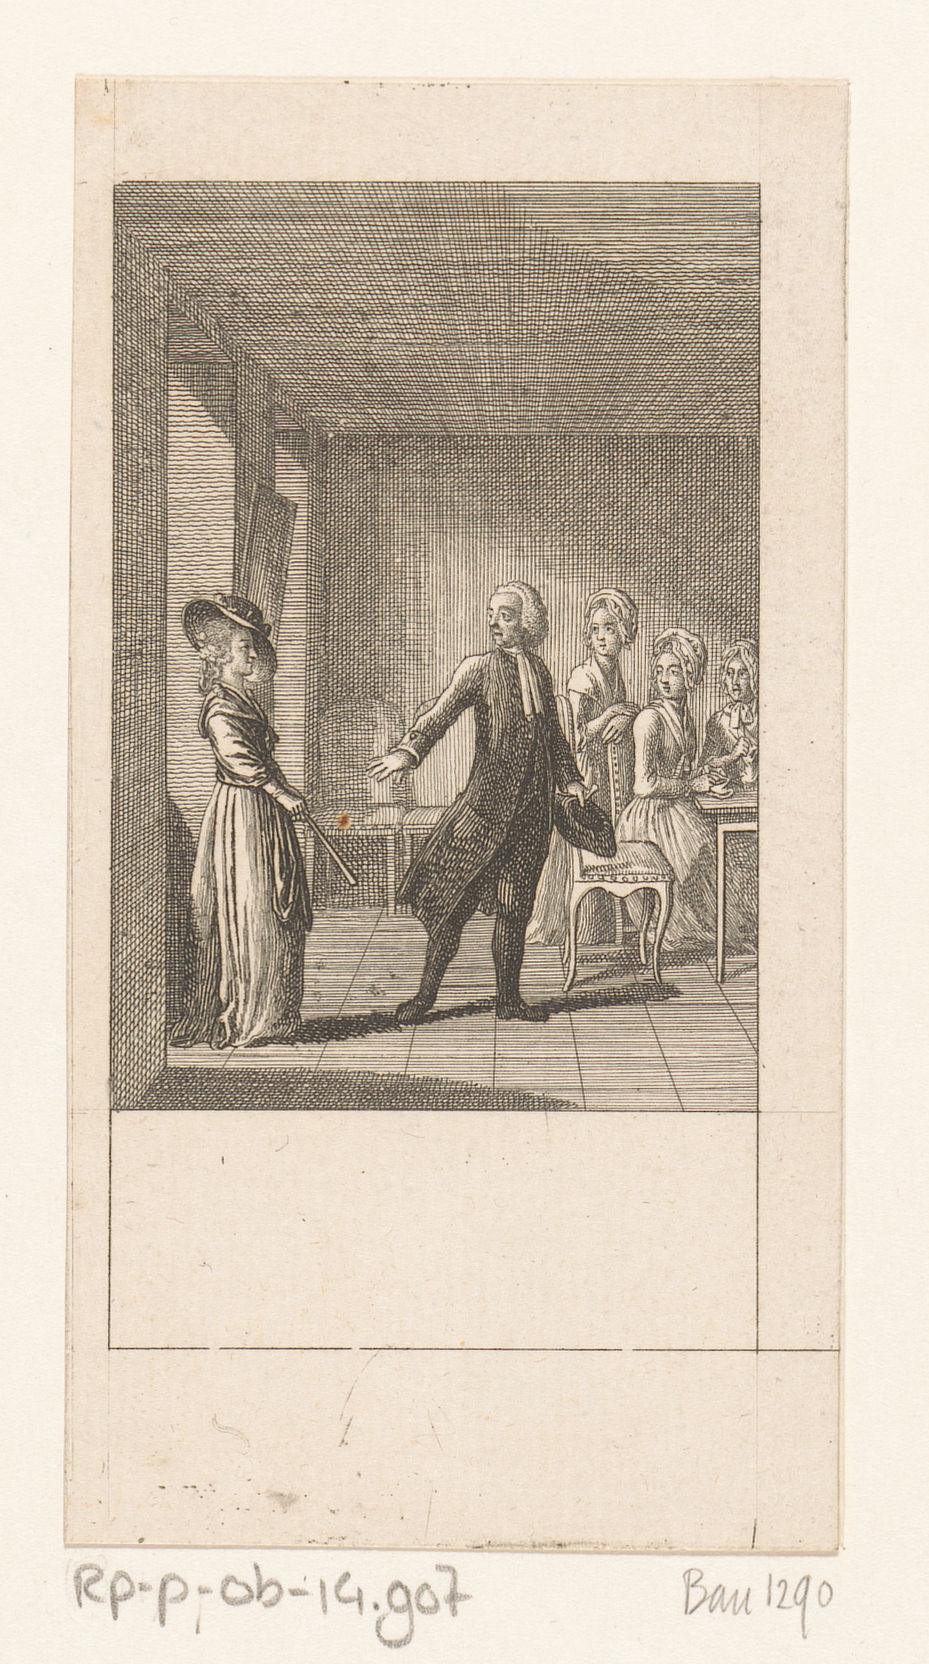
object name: print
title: Camille op bezoek bij de dorpspastoor en zijn familie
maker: daniel nikolaus chodowiecki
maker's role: draughtsman, print maker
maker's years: 1726-1801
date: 1787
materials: paper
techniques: etching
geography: berlin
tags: parents with their children, literature, interior of the house, meeting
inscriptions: collector's mark: Lugt 2228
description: Vervaardigd voor J. F. Jünger's vertaling van 'Camille: oder, Briefe zweyer Mädchen aus unserm Zeitalter'. Een latere staat gebruikt in: Genealogischer Taschenkalender. Auf das Jahr 1788. Berlijn: Königl. Academie der Wissenschaften, 1787.